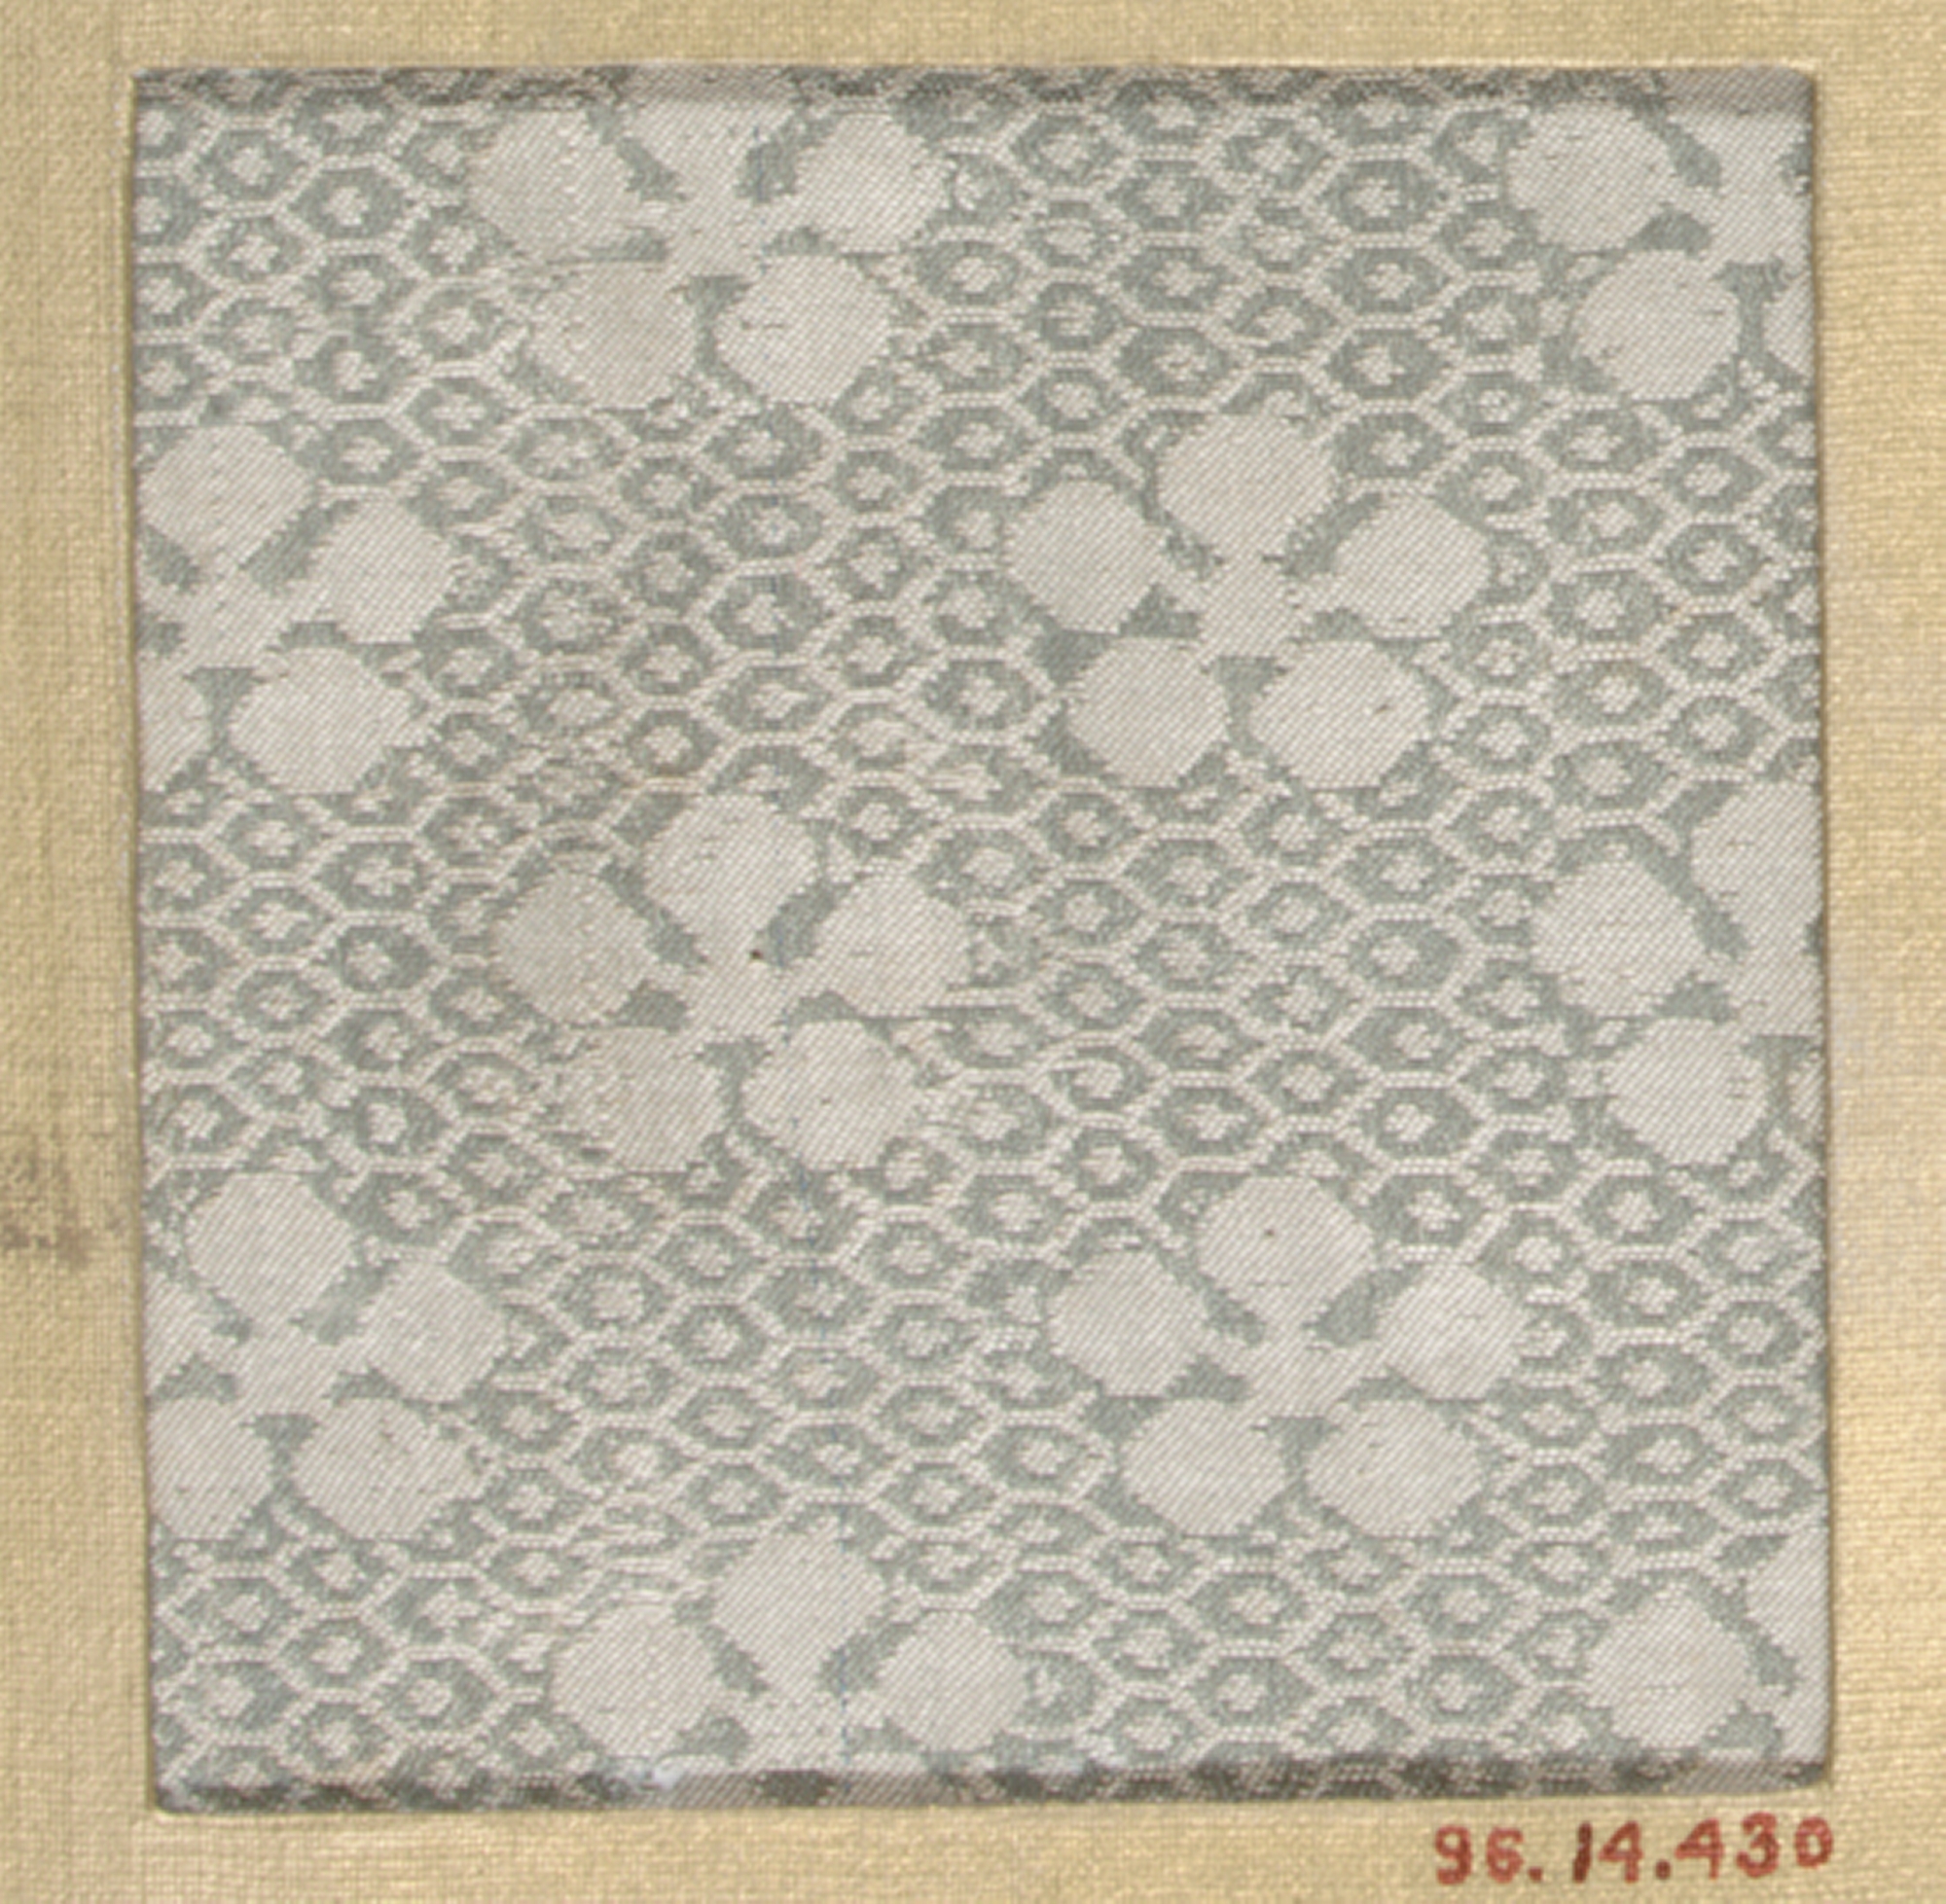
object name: piece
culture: japanese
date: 1701-1900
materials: silk